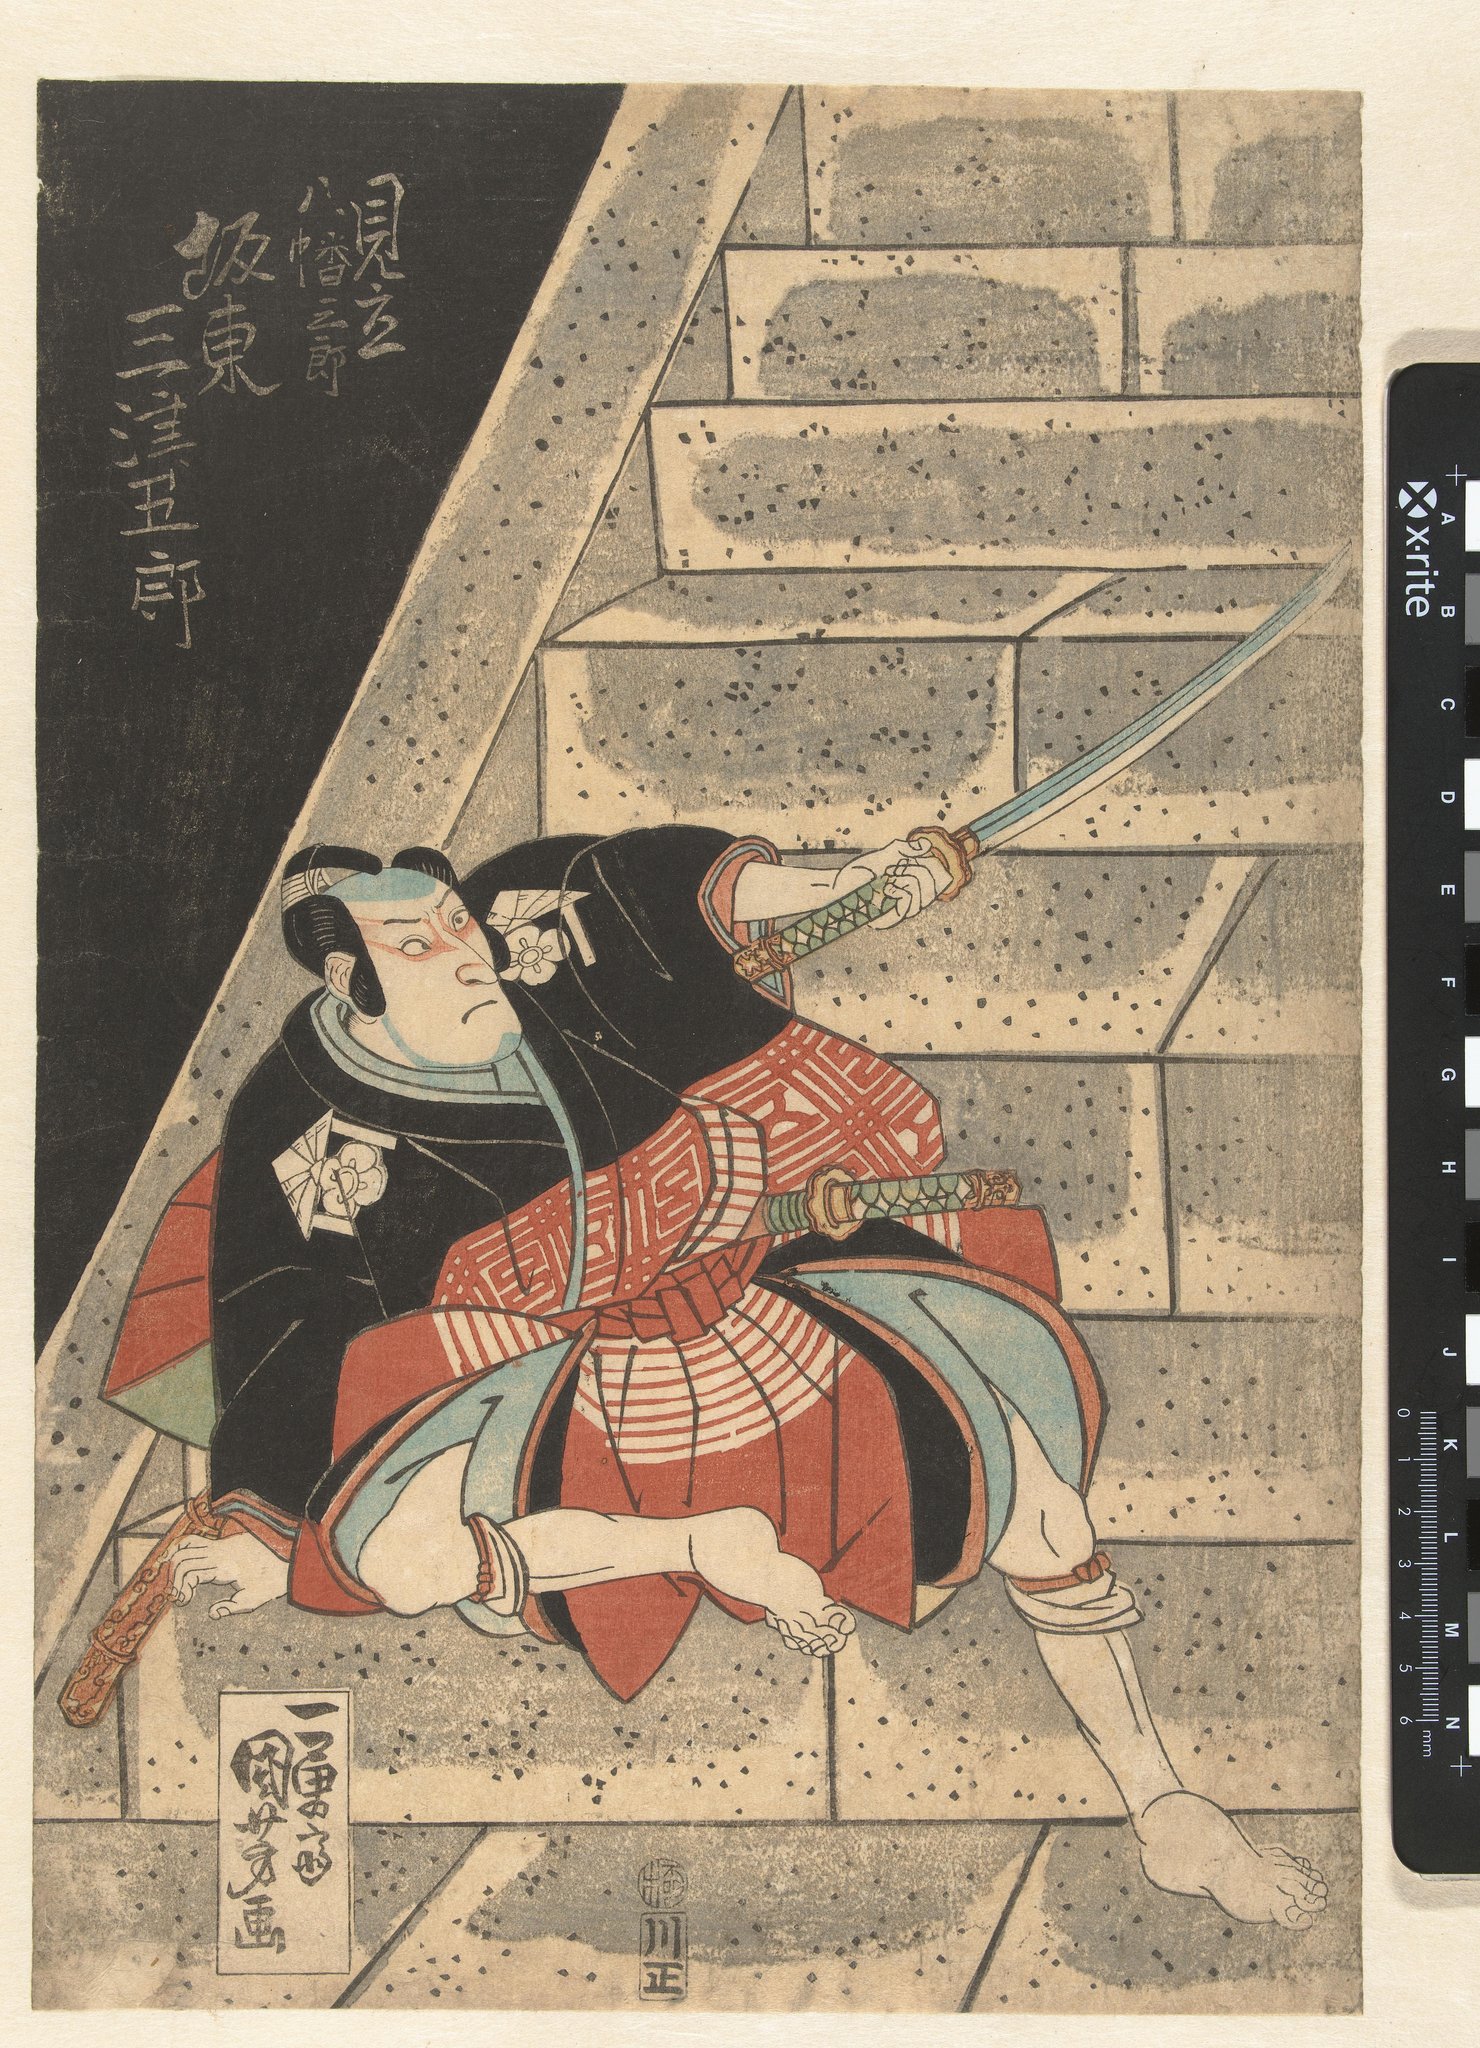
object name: print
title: Bando Mitsugoro op een trap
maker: utagawa kuniyoshi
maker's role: draughtsman, print maker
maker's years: 1798-1861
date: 1815-1842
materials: paper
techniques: woodcut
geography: japan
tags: flight of steps, hacking and thrusting weapons: sword, portrait of actor, actress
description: De acteur Bando Mitsugoro, zittend op stenen trap, met getrokken zwaard.